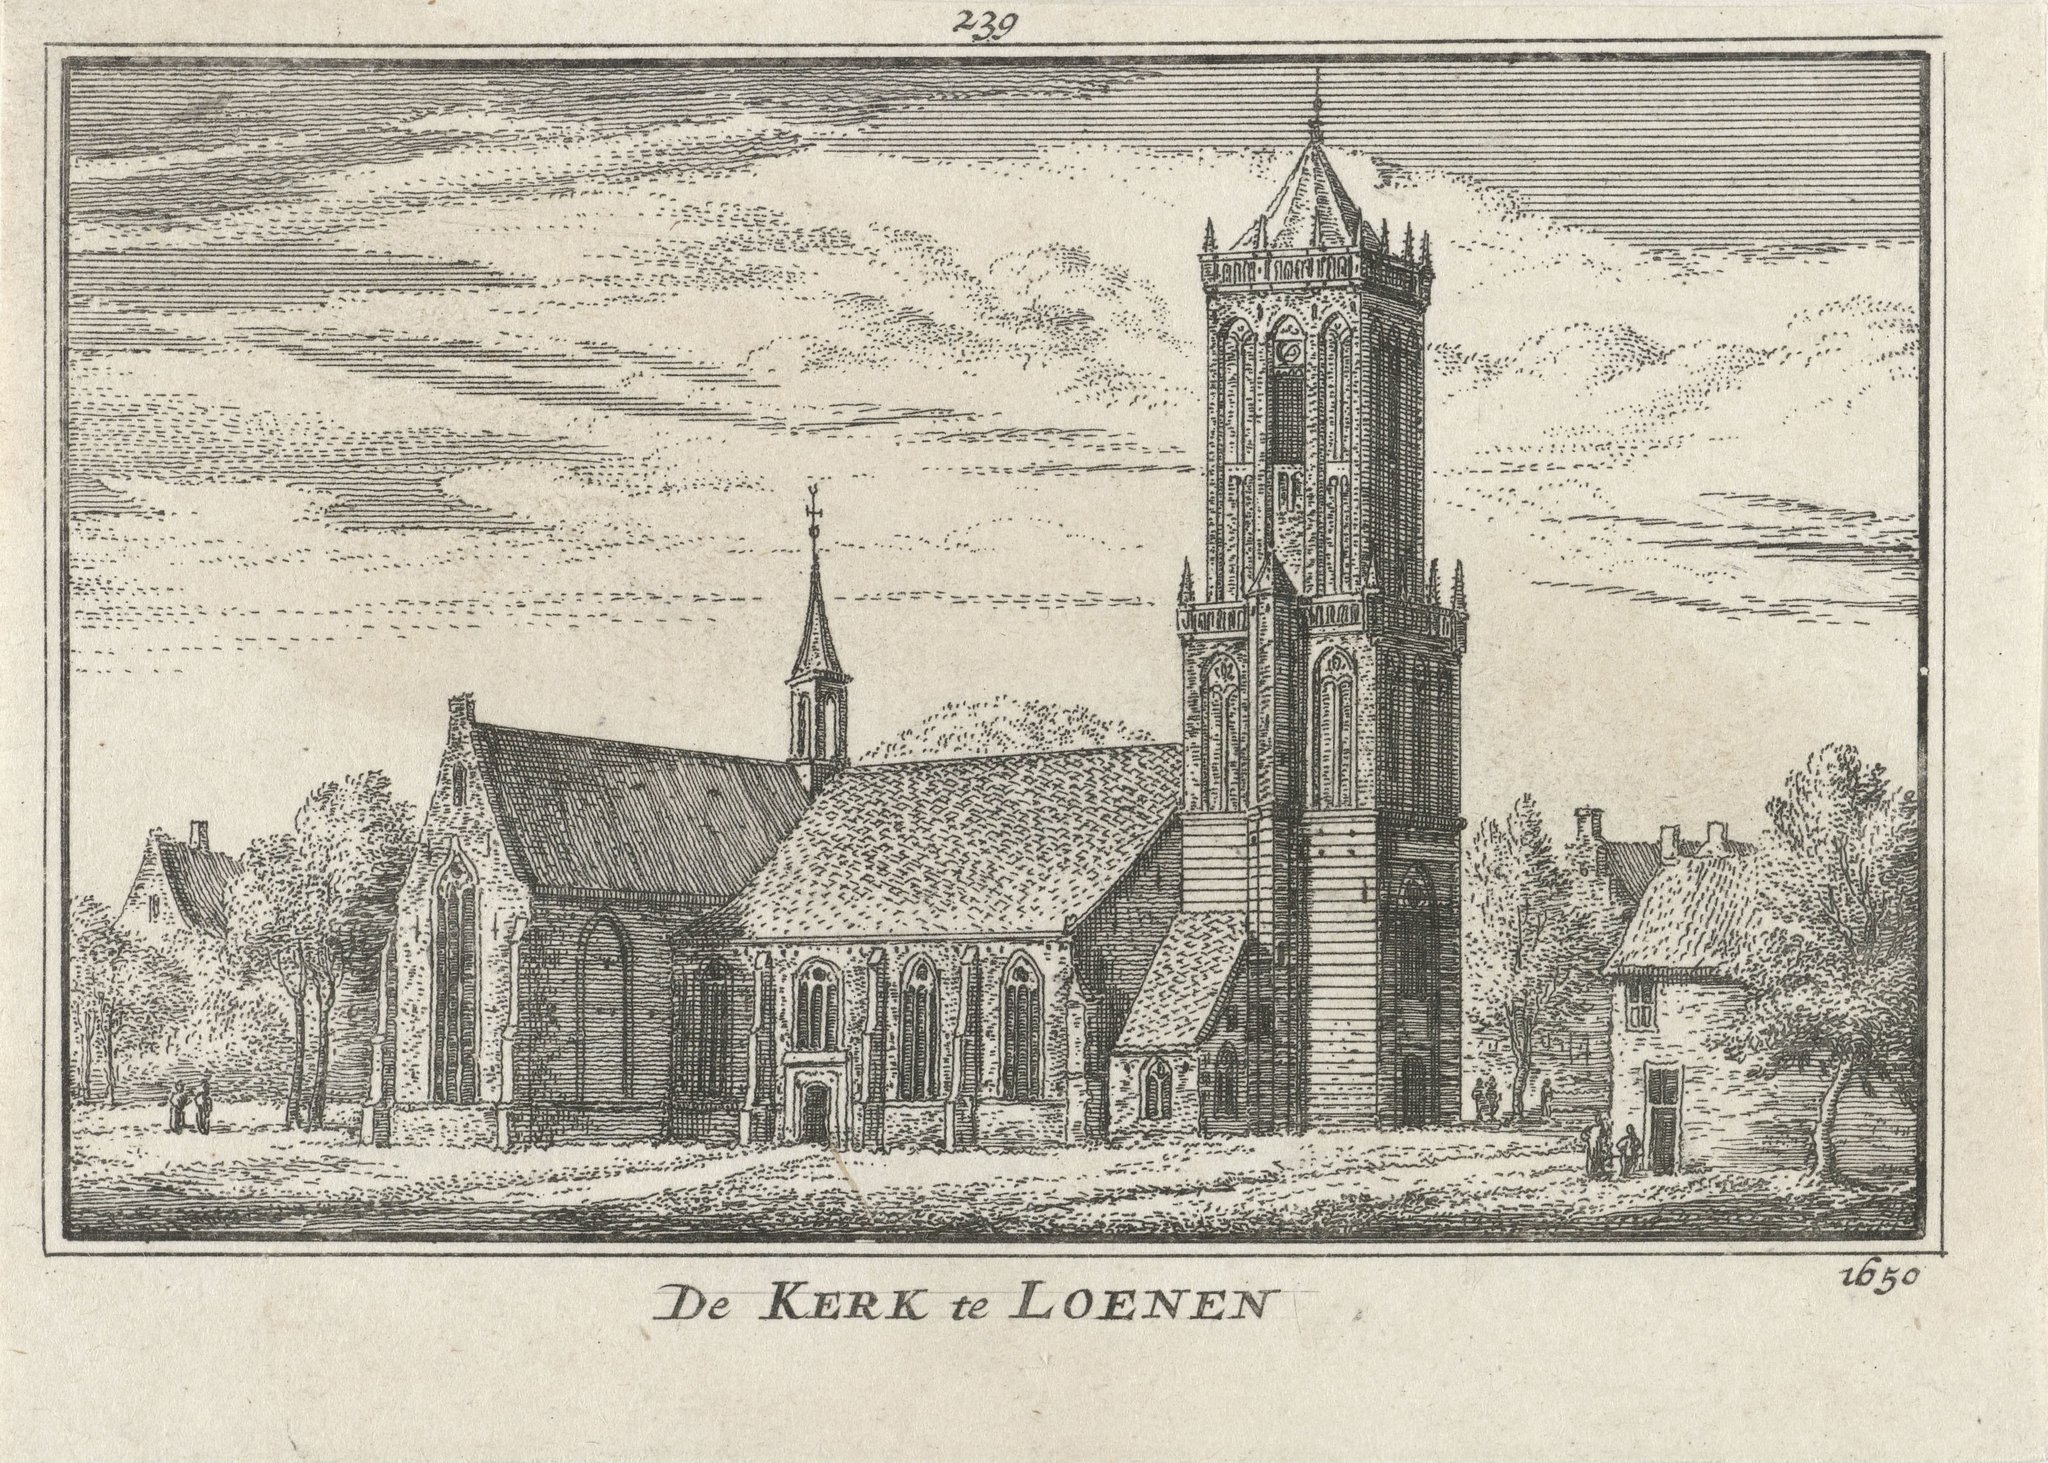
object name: print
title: De kerk te Loenen 1650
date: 1727-1733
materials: paper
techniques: etching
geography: amsterdam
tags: church (exterior)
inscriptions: collector's mark: Lugt 2228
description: Illustratie uit: Abraham Rademaker, Matthaeus Brouërius van Niedek, Isaac Le Long, Kabinet van Nederlandsche en Kleefsche outheden en (...) voorname stads- en landgebouwen, Willem Barents en Antoni Schoonenburg: Amsterdam, 1727-1733, ill. nr. 239.